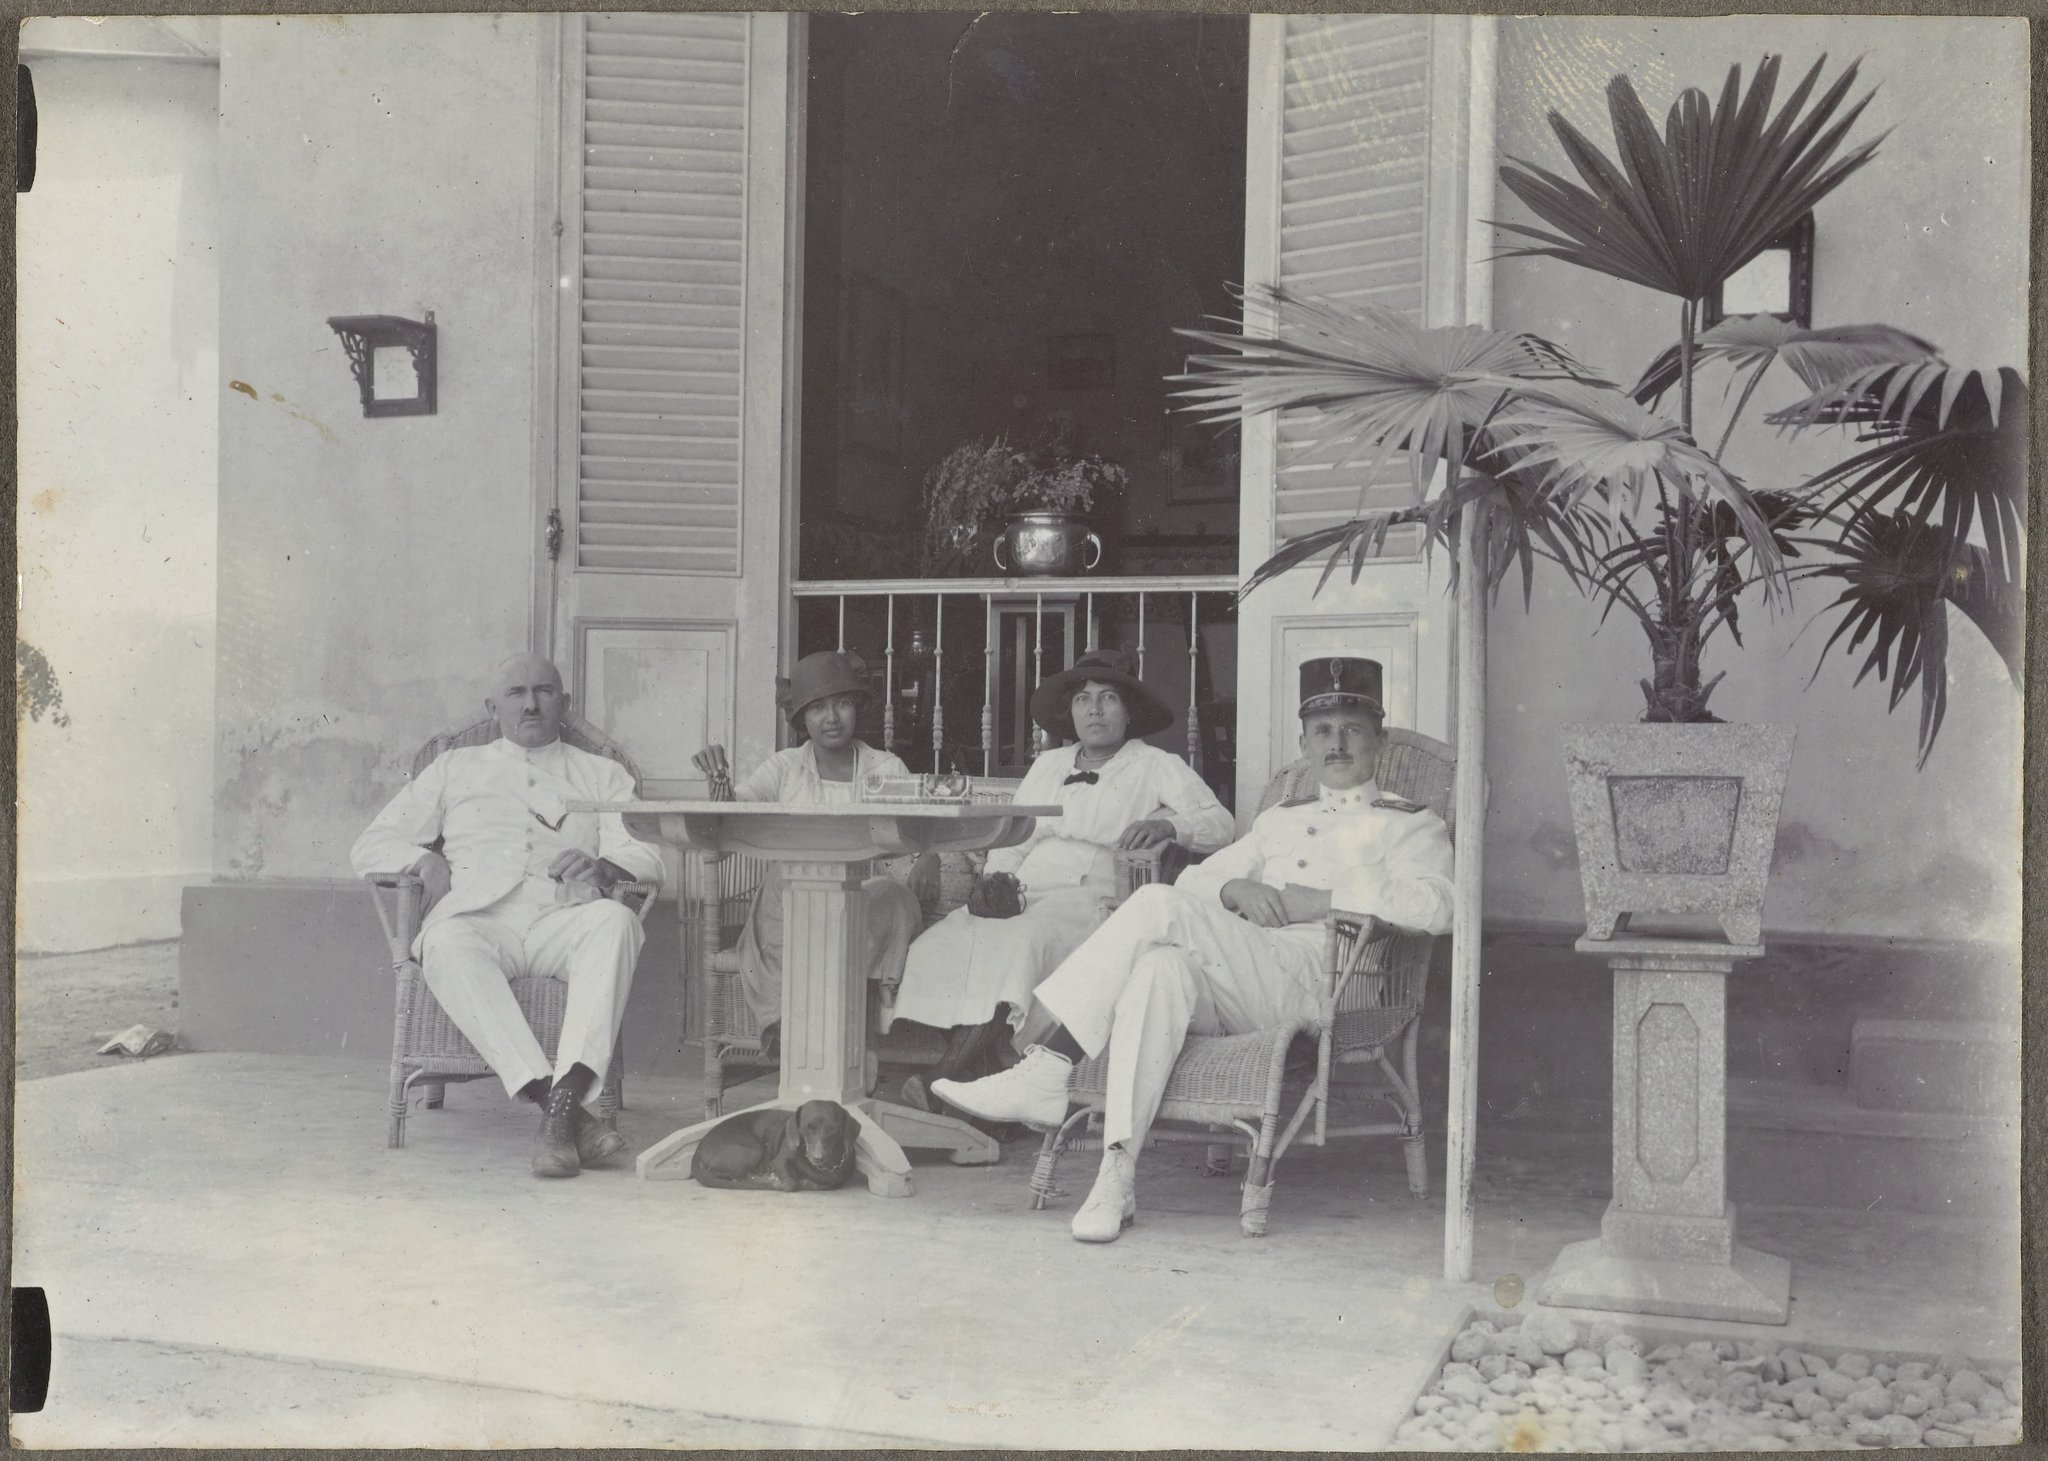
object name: photograph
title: Groepsortret op veranda van twee mannen in uniform en twee vrouwen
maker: Anonymous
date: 1912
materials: photographic support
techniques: collodion silver print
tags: indonesia